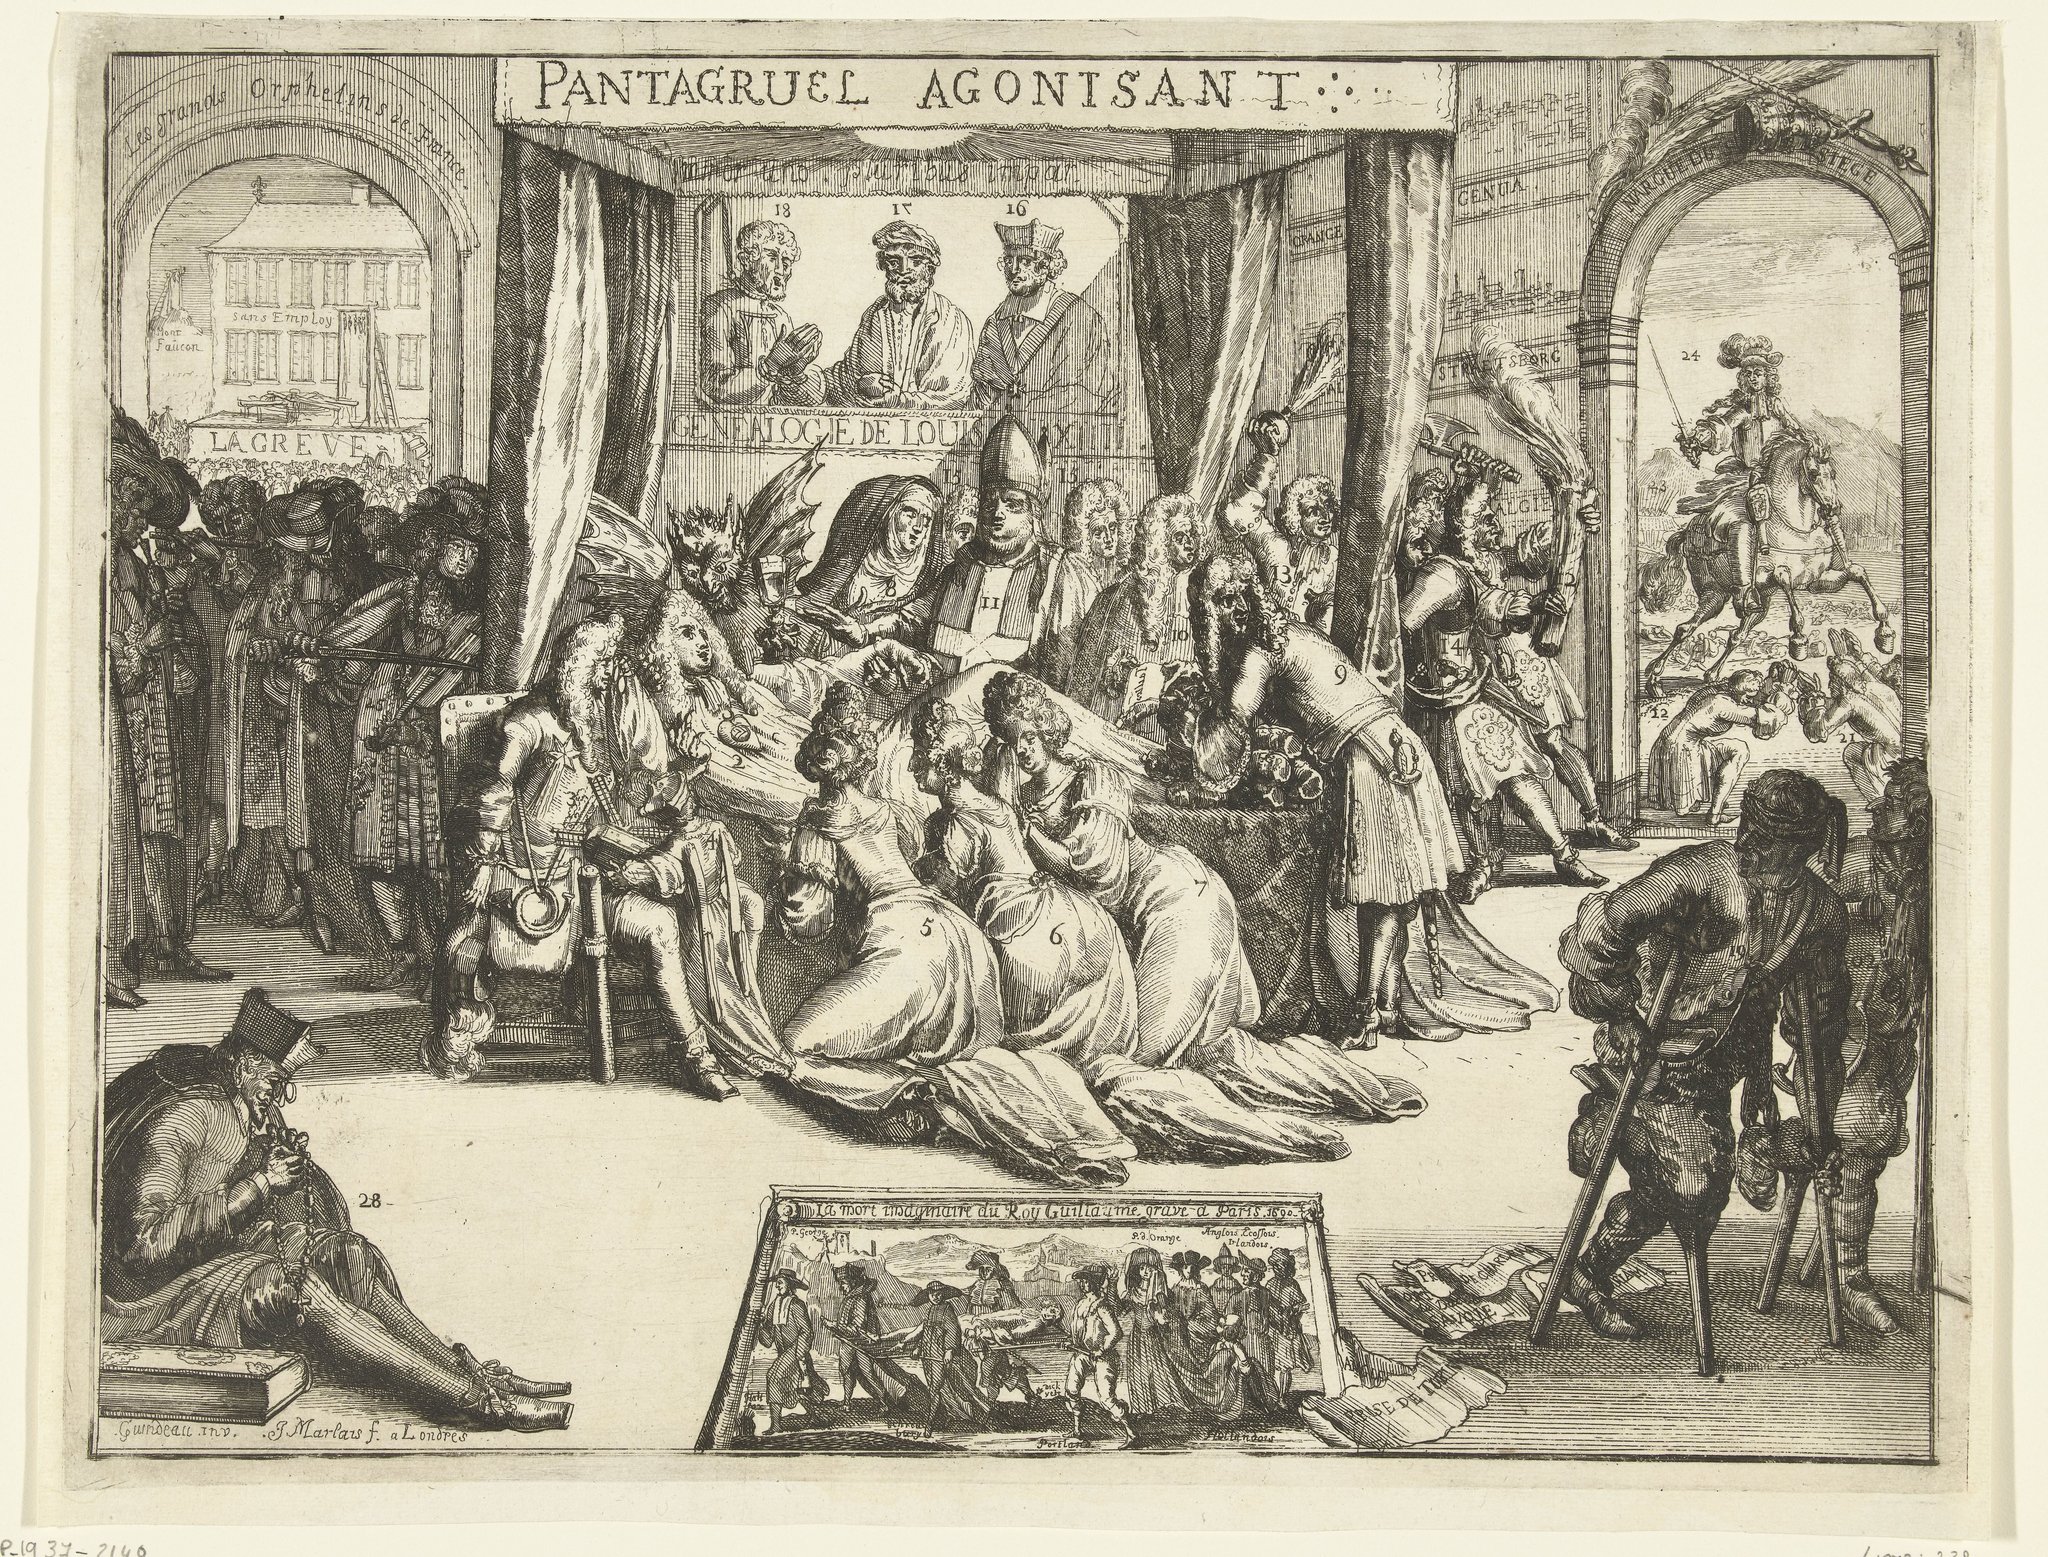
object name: cartoon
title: Pantagruel agonisant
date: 1690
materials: paper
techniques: etching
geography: london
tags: jacobus ii (koning van engeland en schotland), william iii (prince of orange and king of england, scotland, and ireland), lodewijk xiv (koning van frankrijk), paris, madame de maintenon, françoise-athénaïs (marquise de montespan), london, rome, deathbed